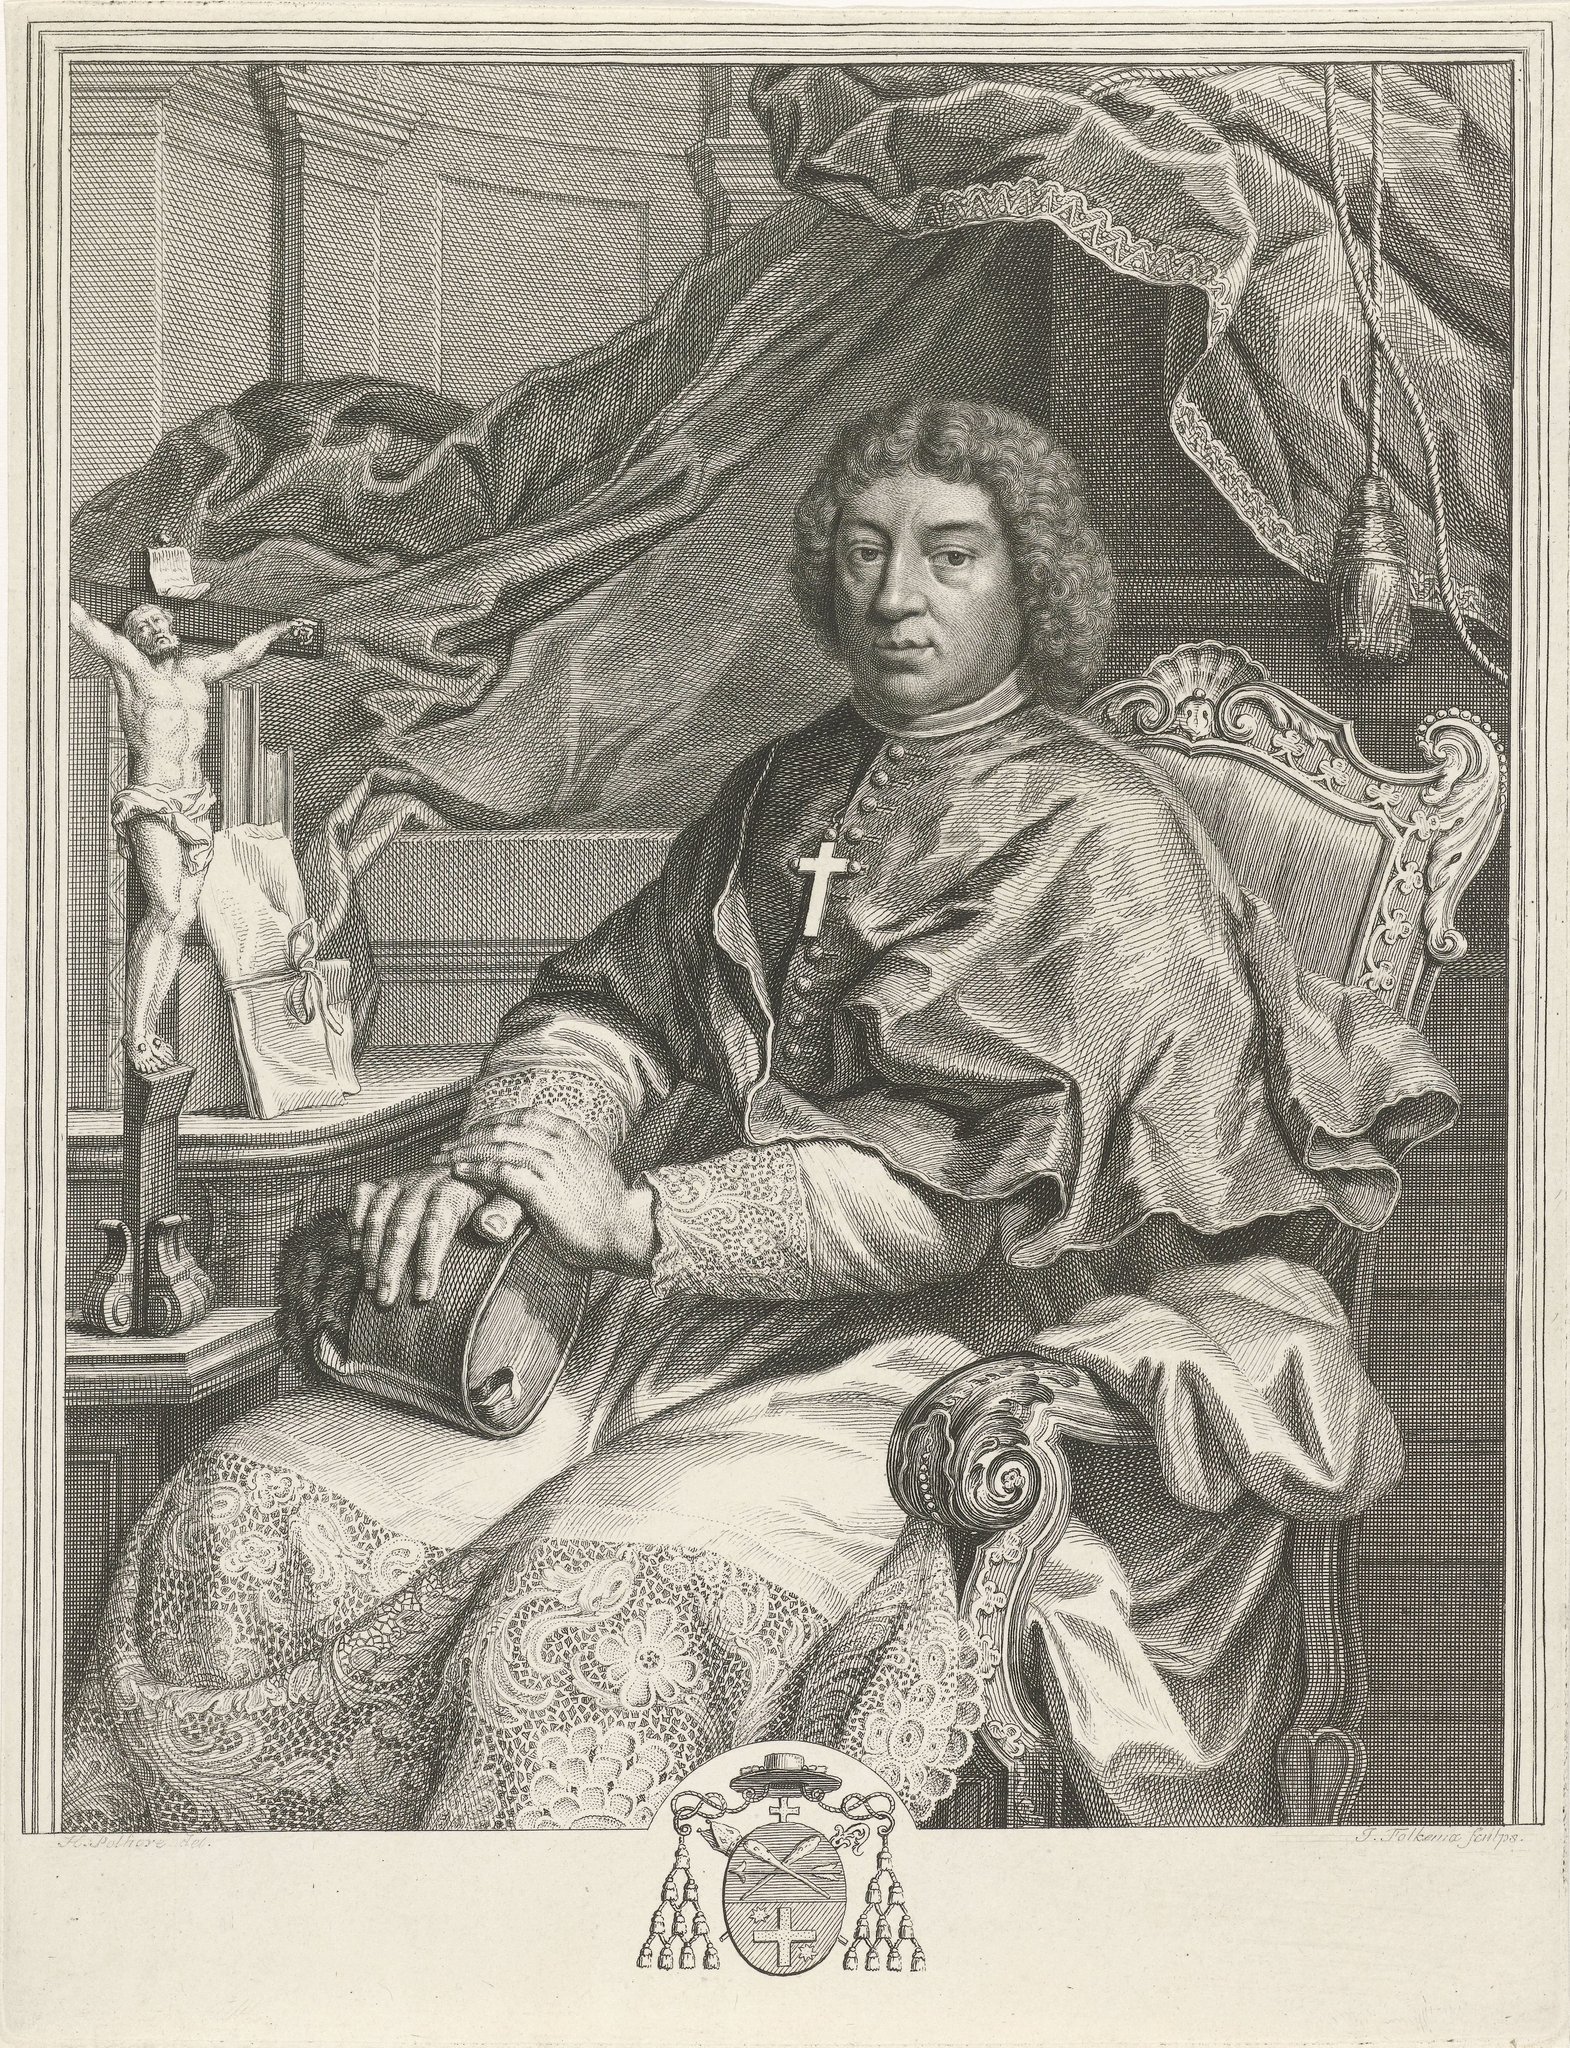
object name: print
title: Portret van een onbekende geestelijke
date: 1735-1767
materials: paper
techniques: engraving, etching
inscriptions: collector's mark: Lugt 240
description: Portret van een onbekende geestelijke, blootshoofds. Kniestuk, zittend in een stoel naar links gedraaid. Zijn beide handen steunen op de biretta die op zijn bovenbeen ligt. Onder het portret staat in de marge het wapen van de geportretteerde.